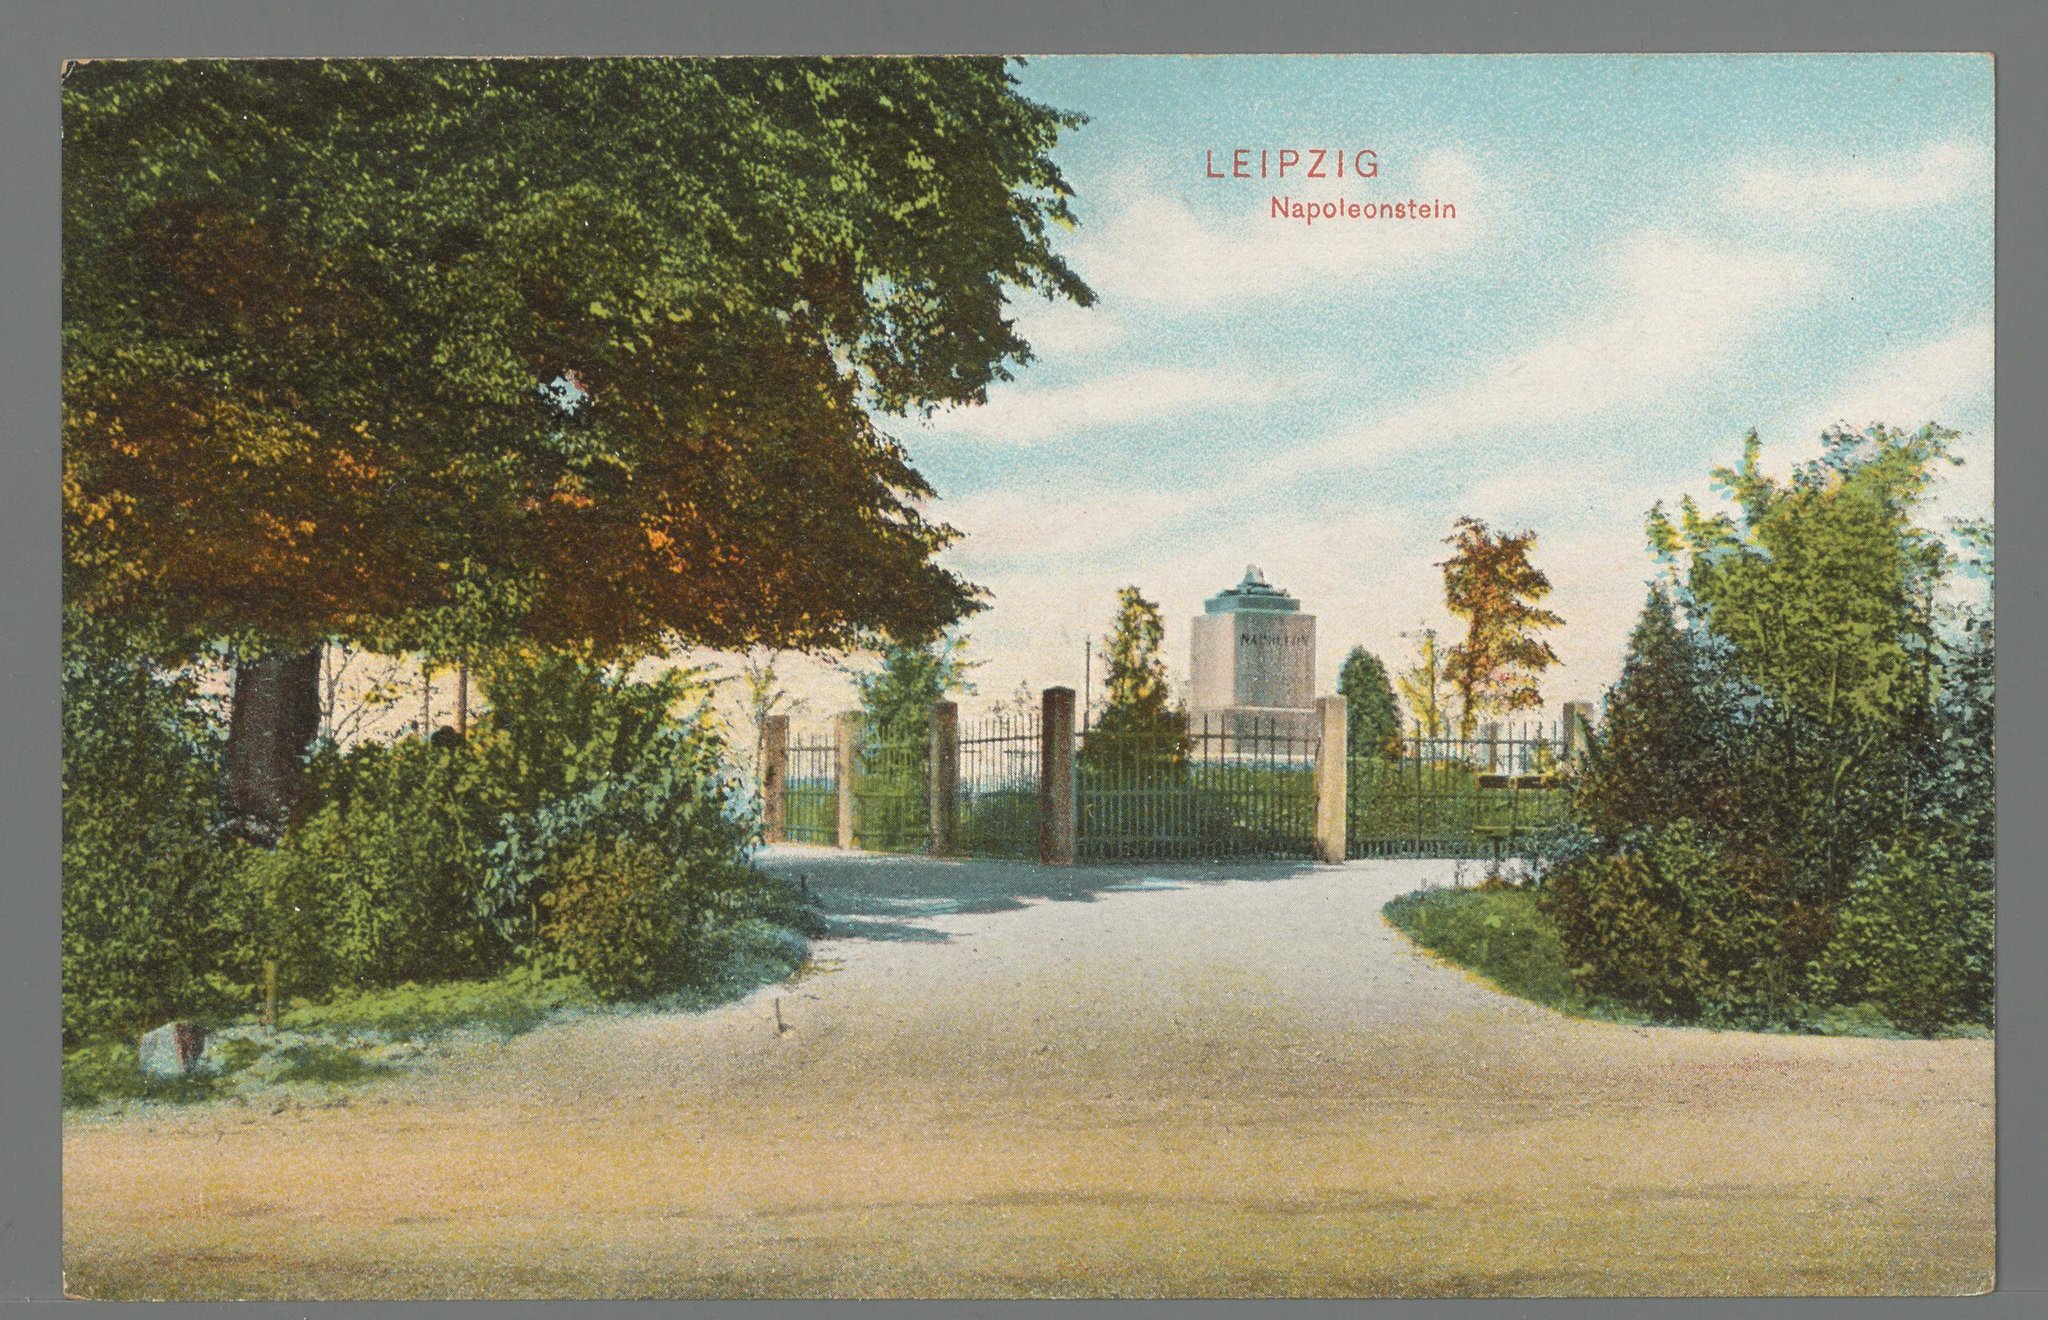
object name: ansichtkaart, prentbriefkaart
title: Leipzig. Napoleonstein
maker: Anonymous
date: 1906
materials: cardboard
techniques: lithograph, writing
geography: leipzig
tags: monument, statue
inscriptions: date